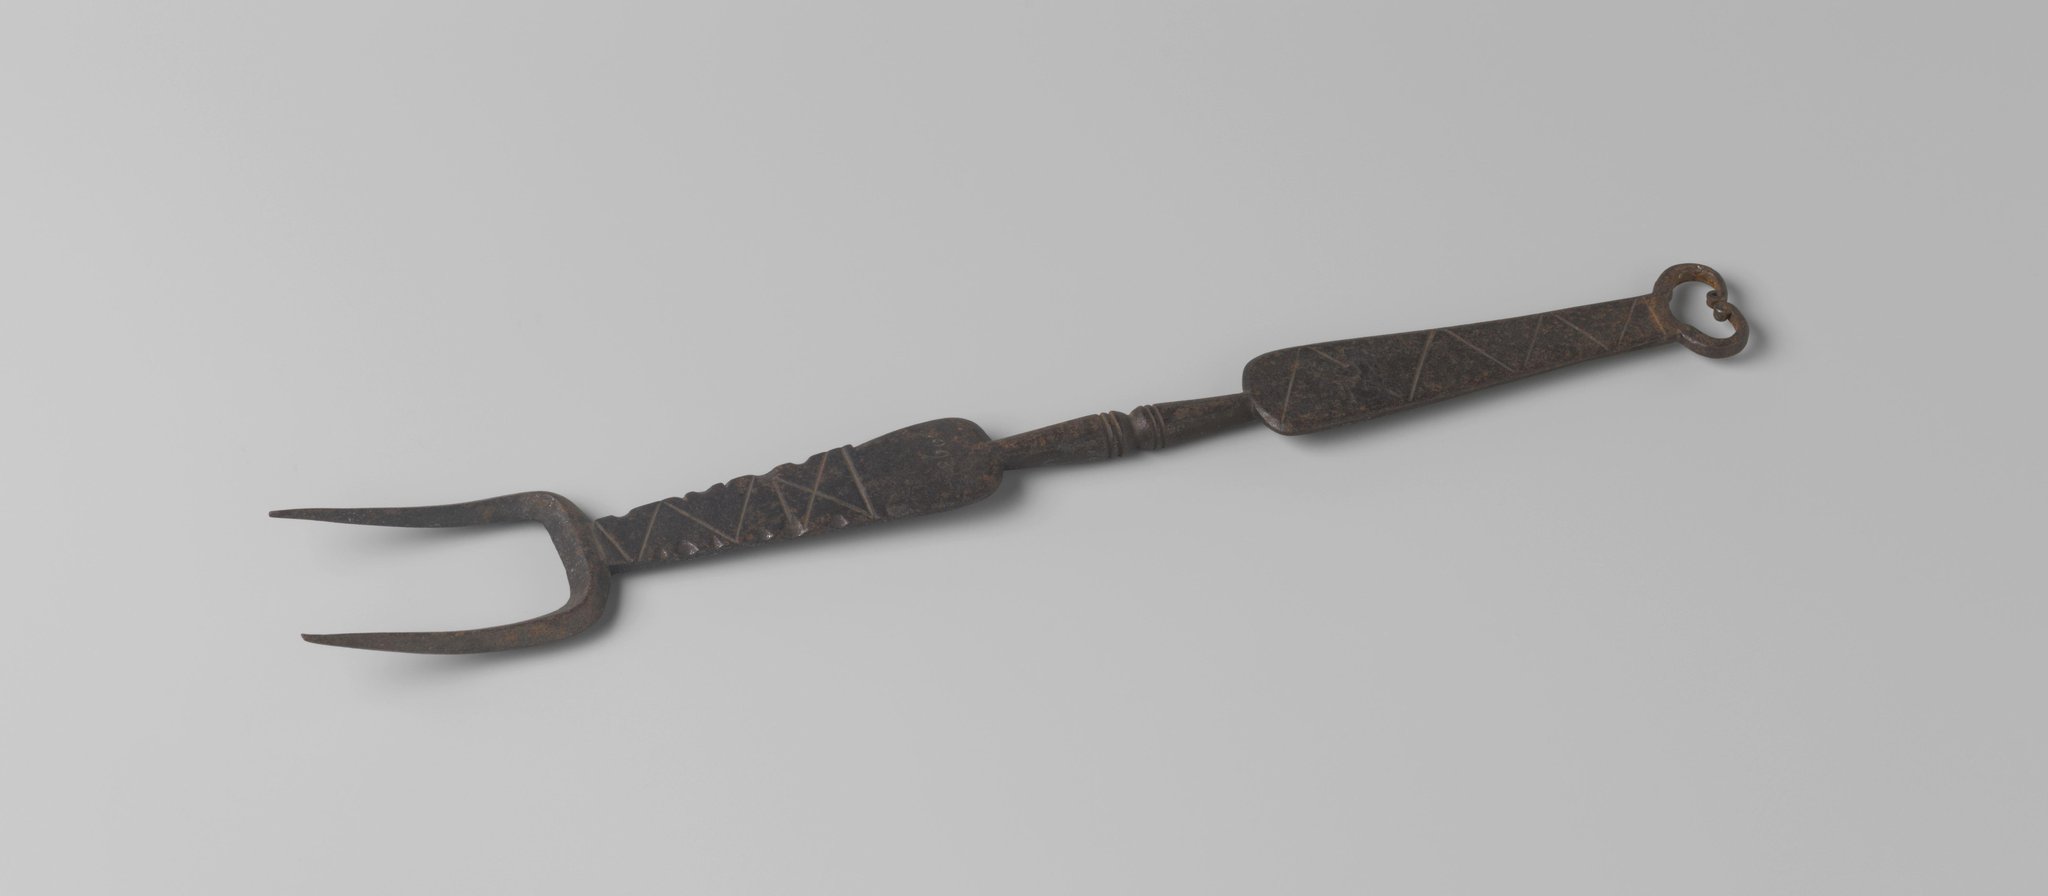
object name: fork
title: Vork met twee tanden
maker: Anonymous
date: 1400-1950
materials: iron